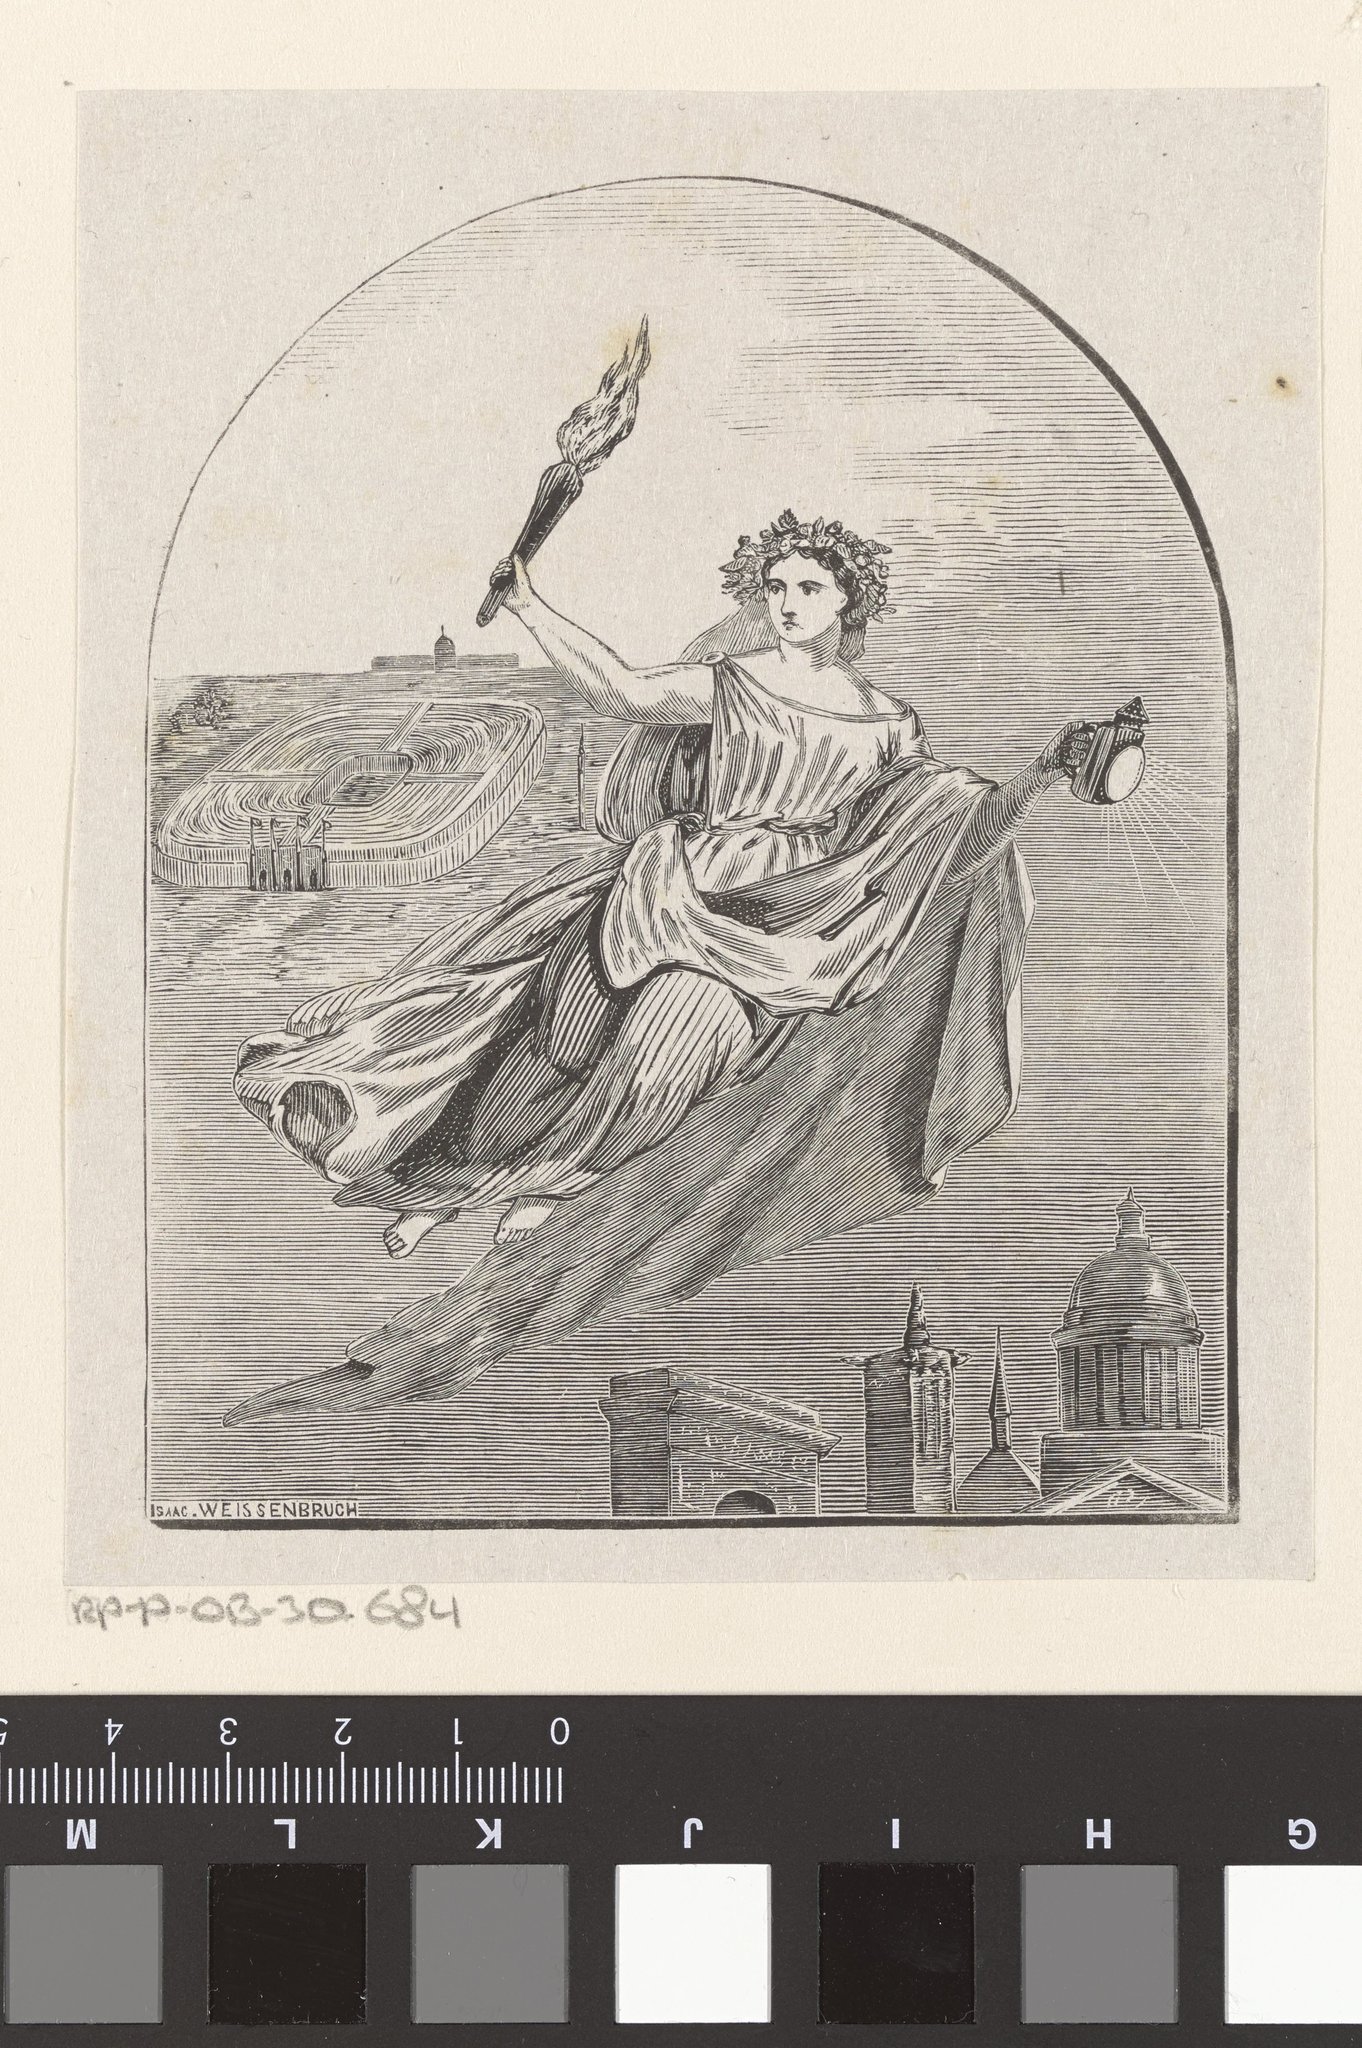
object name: print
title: Allegorische vrouwfiguur met een fakkel en een lantaarn boven een stad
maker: isaac weissenbruch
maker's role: print maker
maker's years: 1826-1912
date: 1836-1912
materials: paper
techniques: engraving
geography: netherlands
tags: torch, city-view in general; 'veduta', lantern